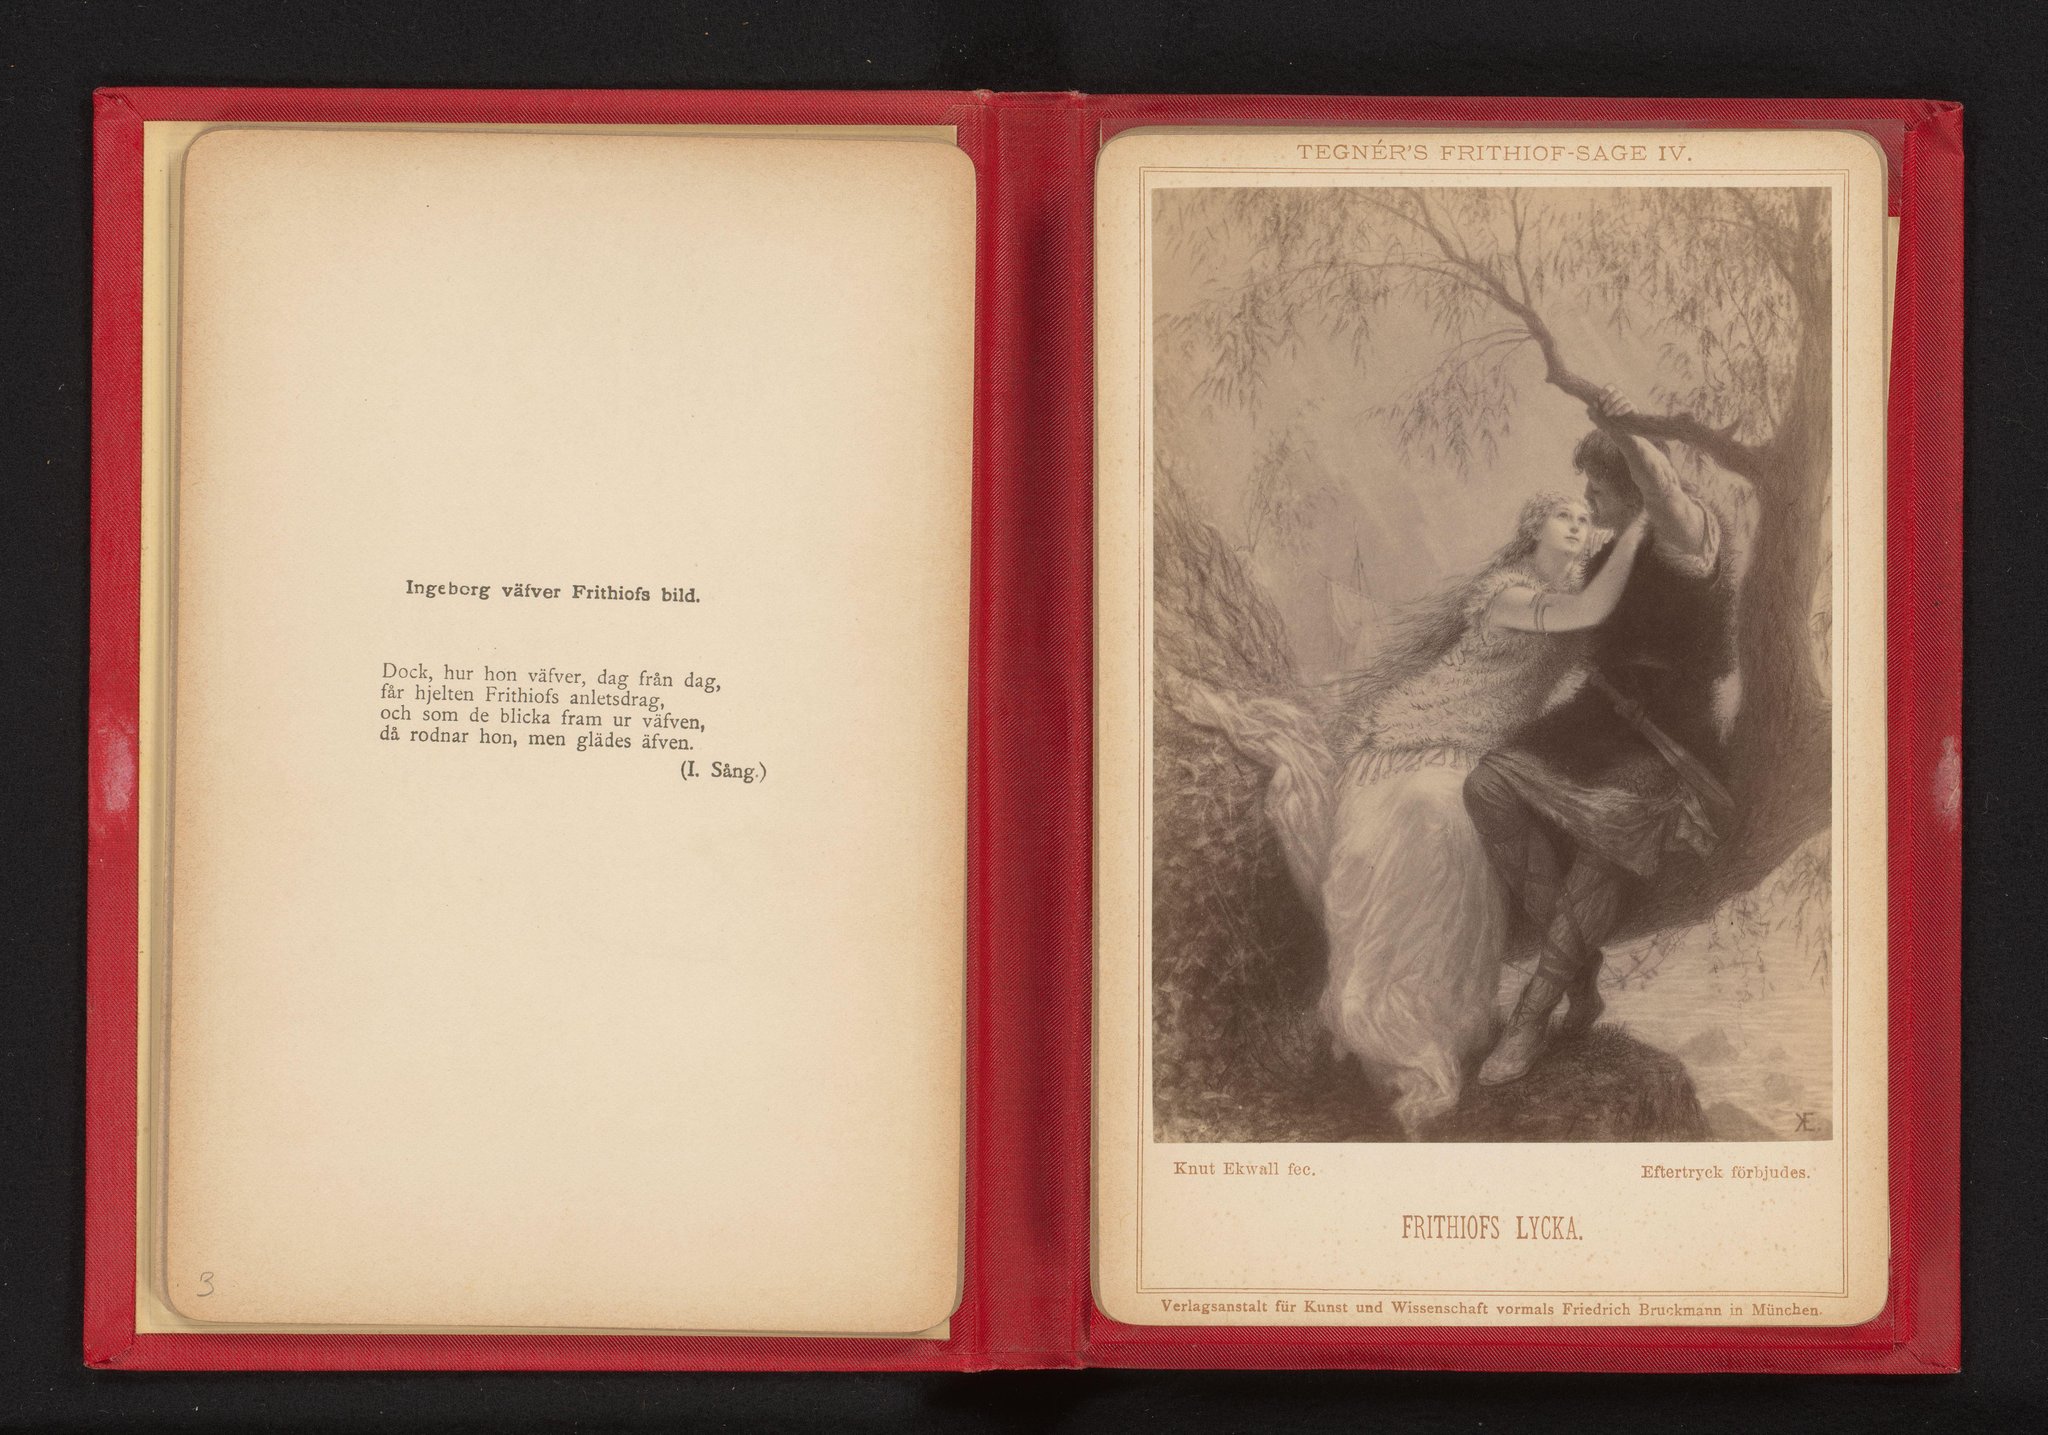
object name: page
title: Frithiofs lycka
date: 1874-1884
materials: photographic support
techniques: albumen print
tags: trees, lovers' meeting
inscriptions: number: ‘IV.’